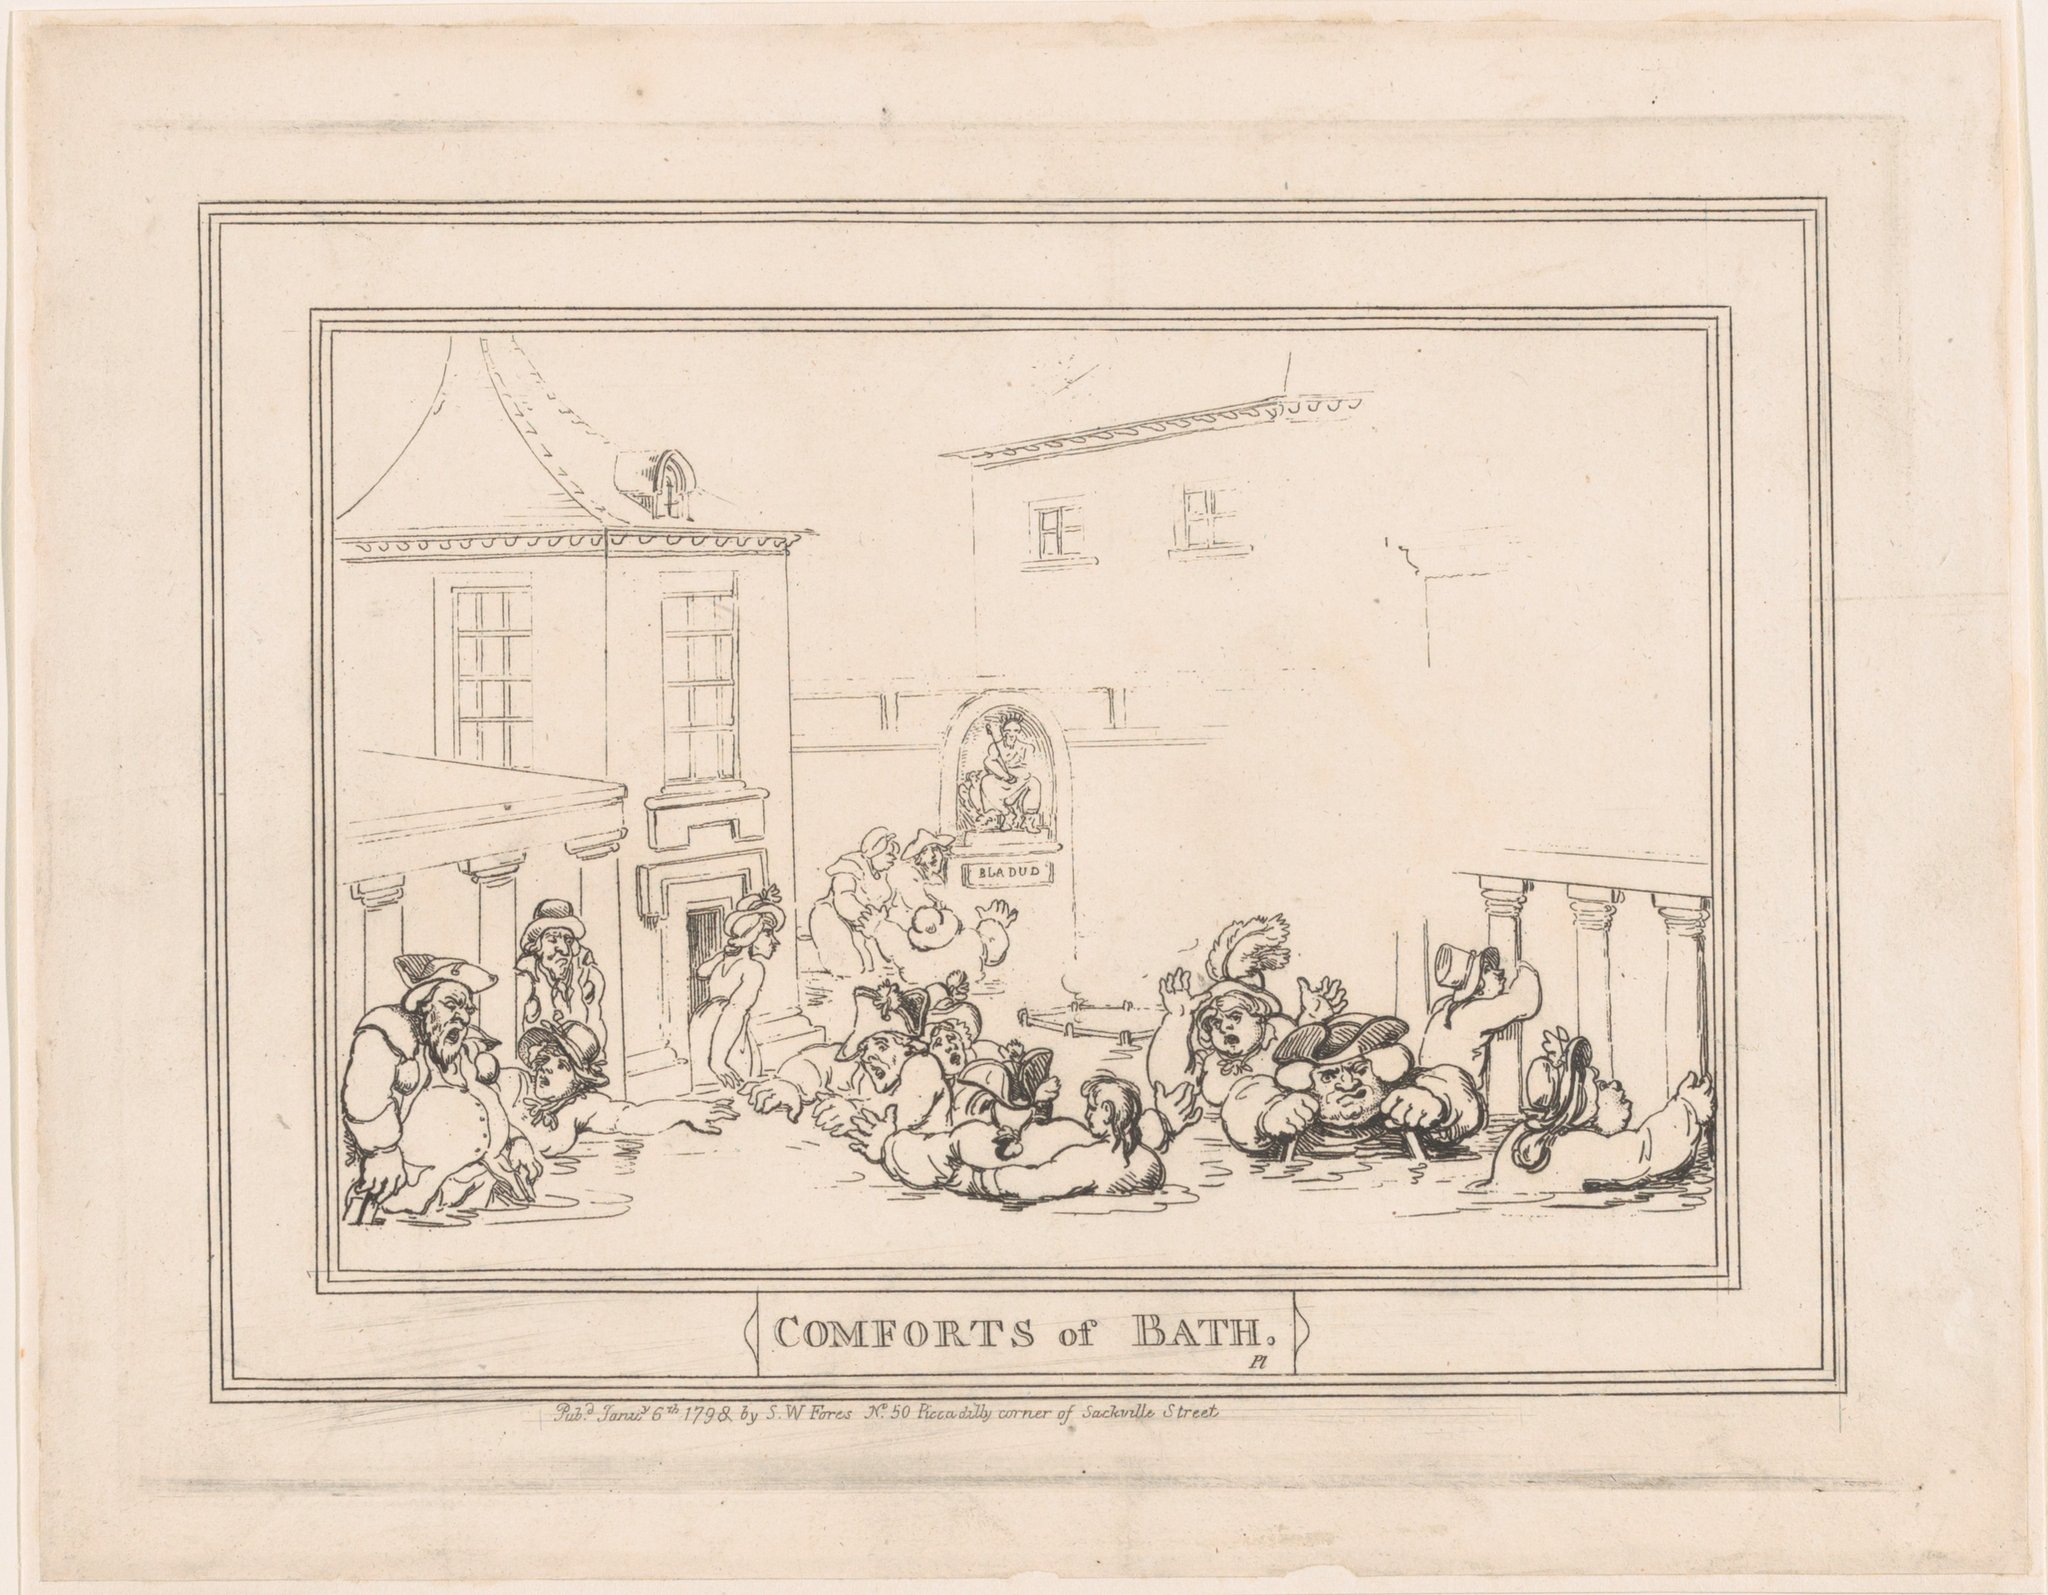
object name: print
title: Comforts of Bath, Plate 7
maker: thomas rowlandson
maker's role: artist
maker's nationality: british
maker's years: 1757-1827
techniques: etching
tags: satire,men,women